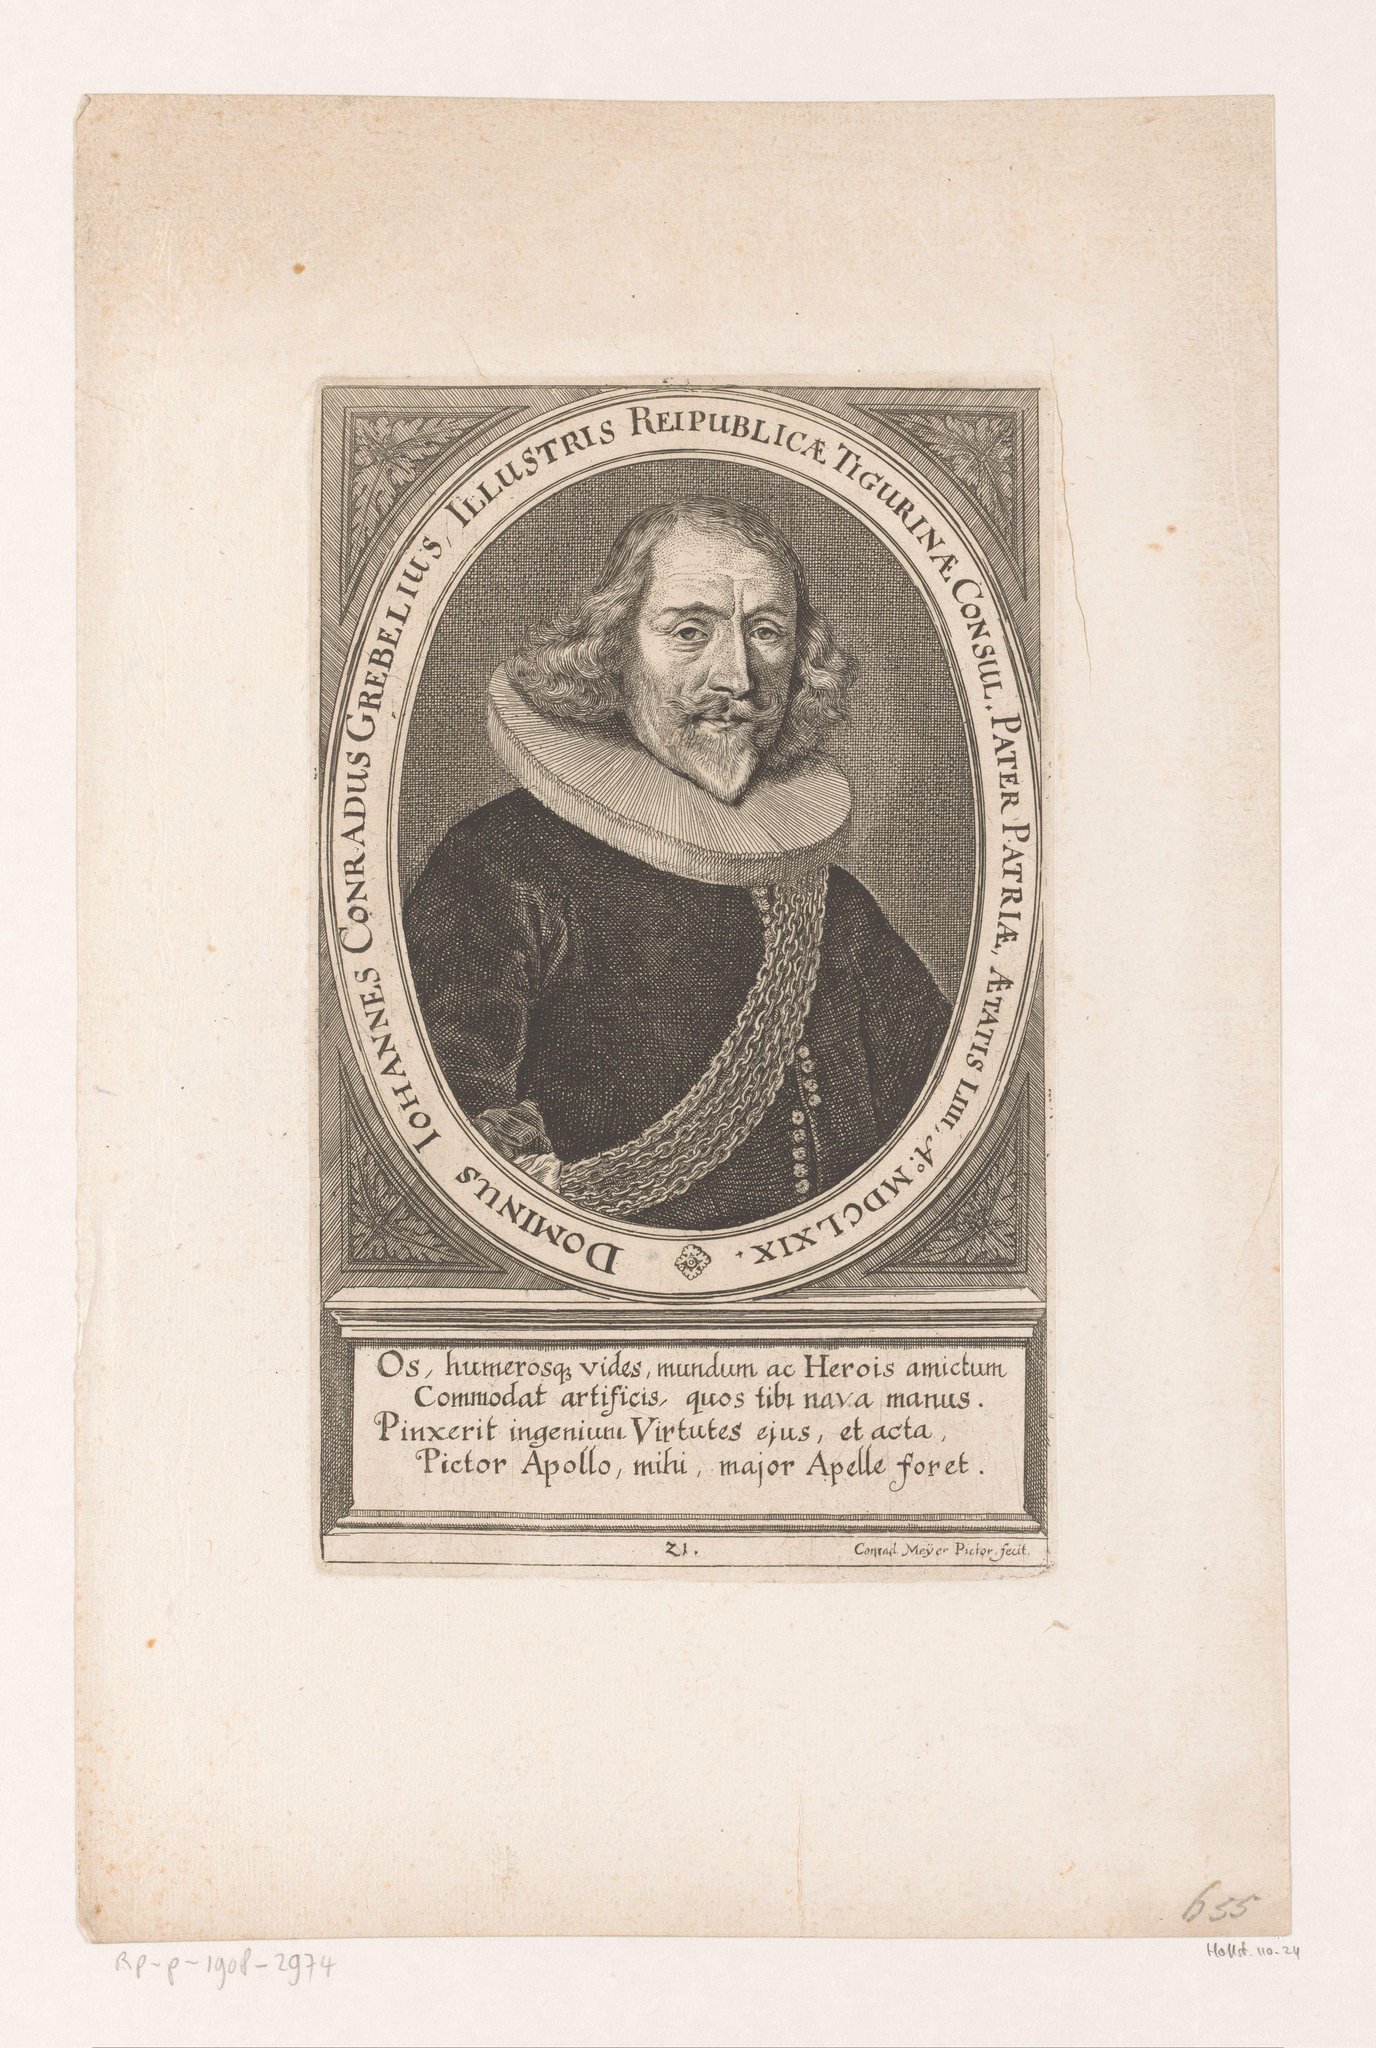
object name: print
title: Portretten van burgemeesters van Zürich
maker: conrad meyer (i)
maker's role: painter, print maker, publisher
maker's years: 1618-1689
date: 1669-1689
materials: paper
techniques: engraving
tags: mayor, other non-personal regalia, e.g. mayor chain, historical persons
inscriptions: collector's mark: Lugt 2228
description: Onderdeel van een serie van 67(?) portretten van burgemeesters van Zürich. Zie Hollstein German 110, 1-26.